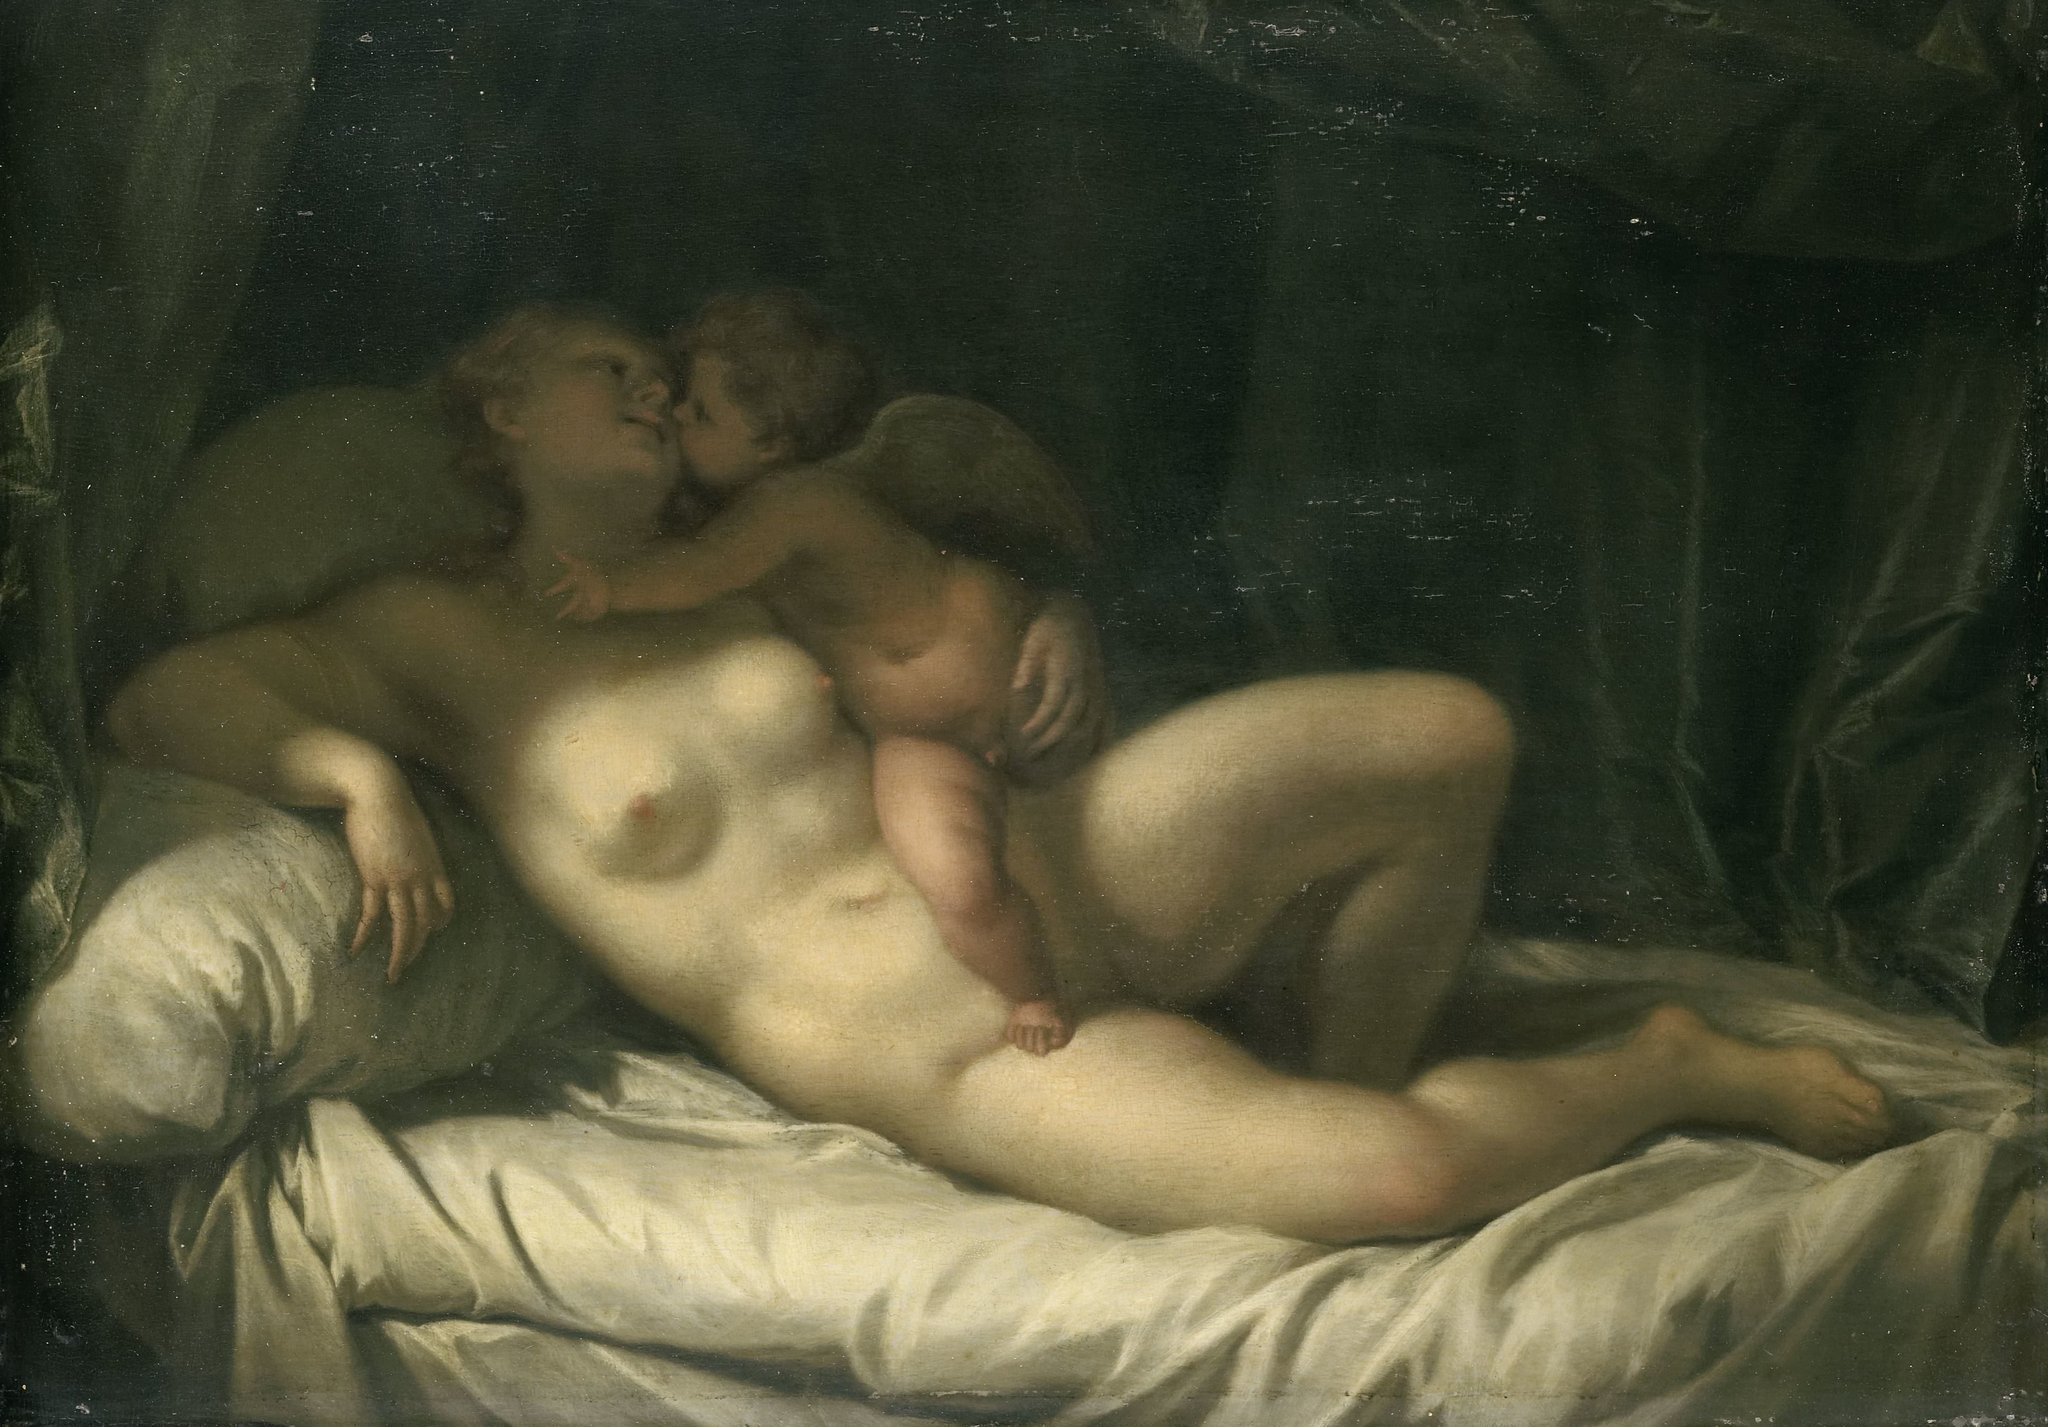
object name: painting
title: Amor Kissing Venus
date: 1700-1725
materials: oil, panel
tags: lying figure - aa - female human figure, venus and cupid (cupid not being mere attribute)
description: Venus door Amor gekust. Venus ligt languit naakt op een bed. Amor staat op haar schoot en kust haar op de wang.